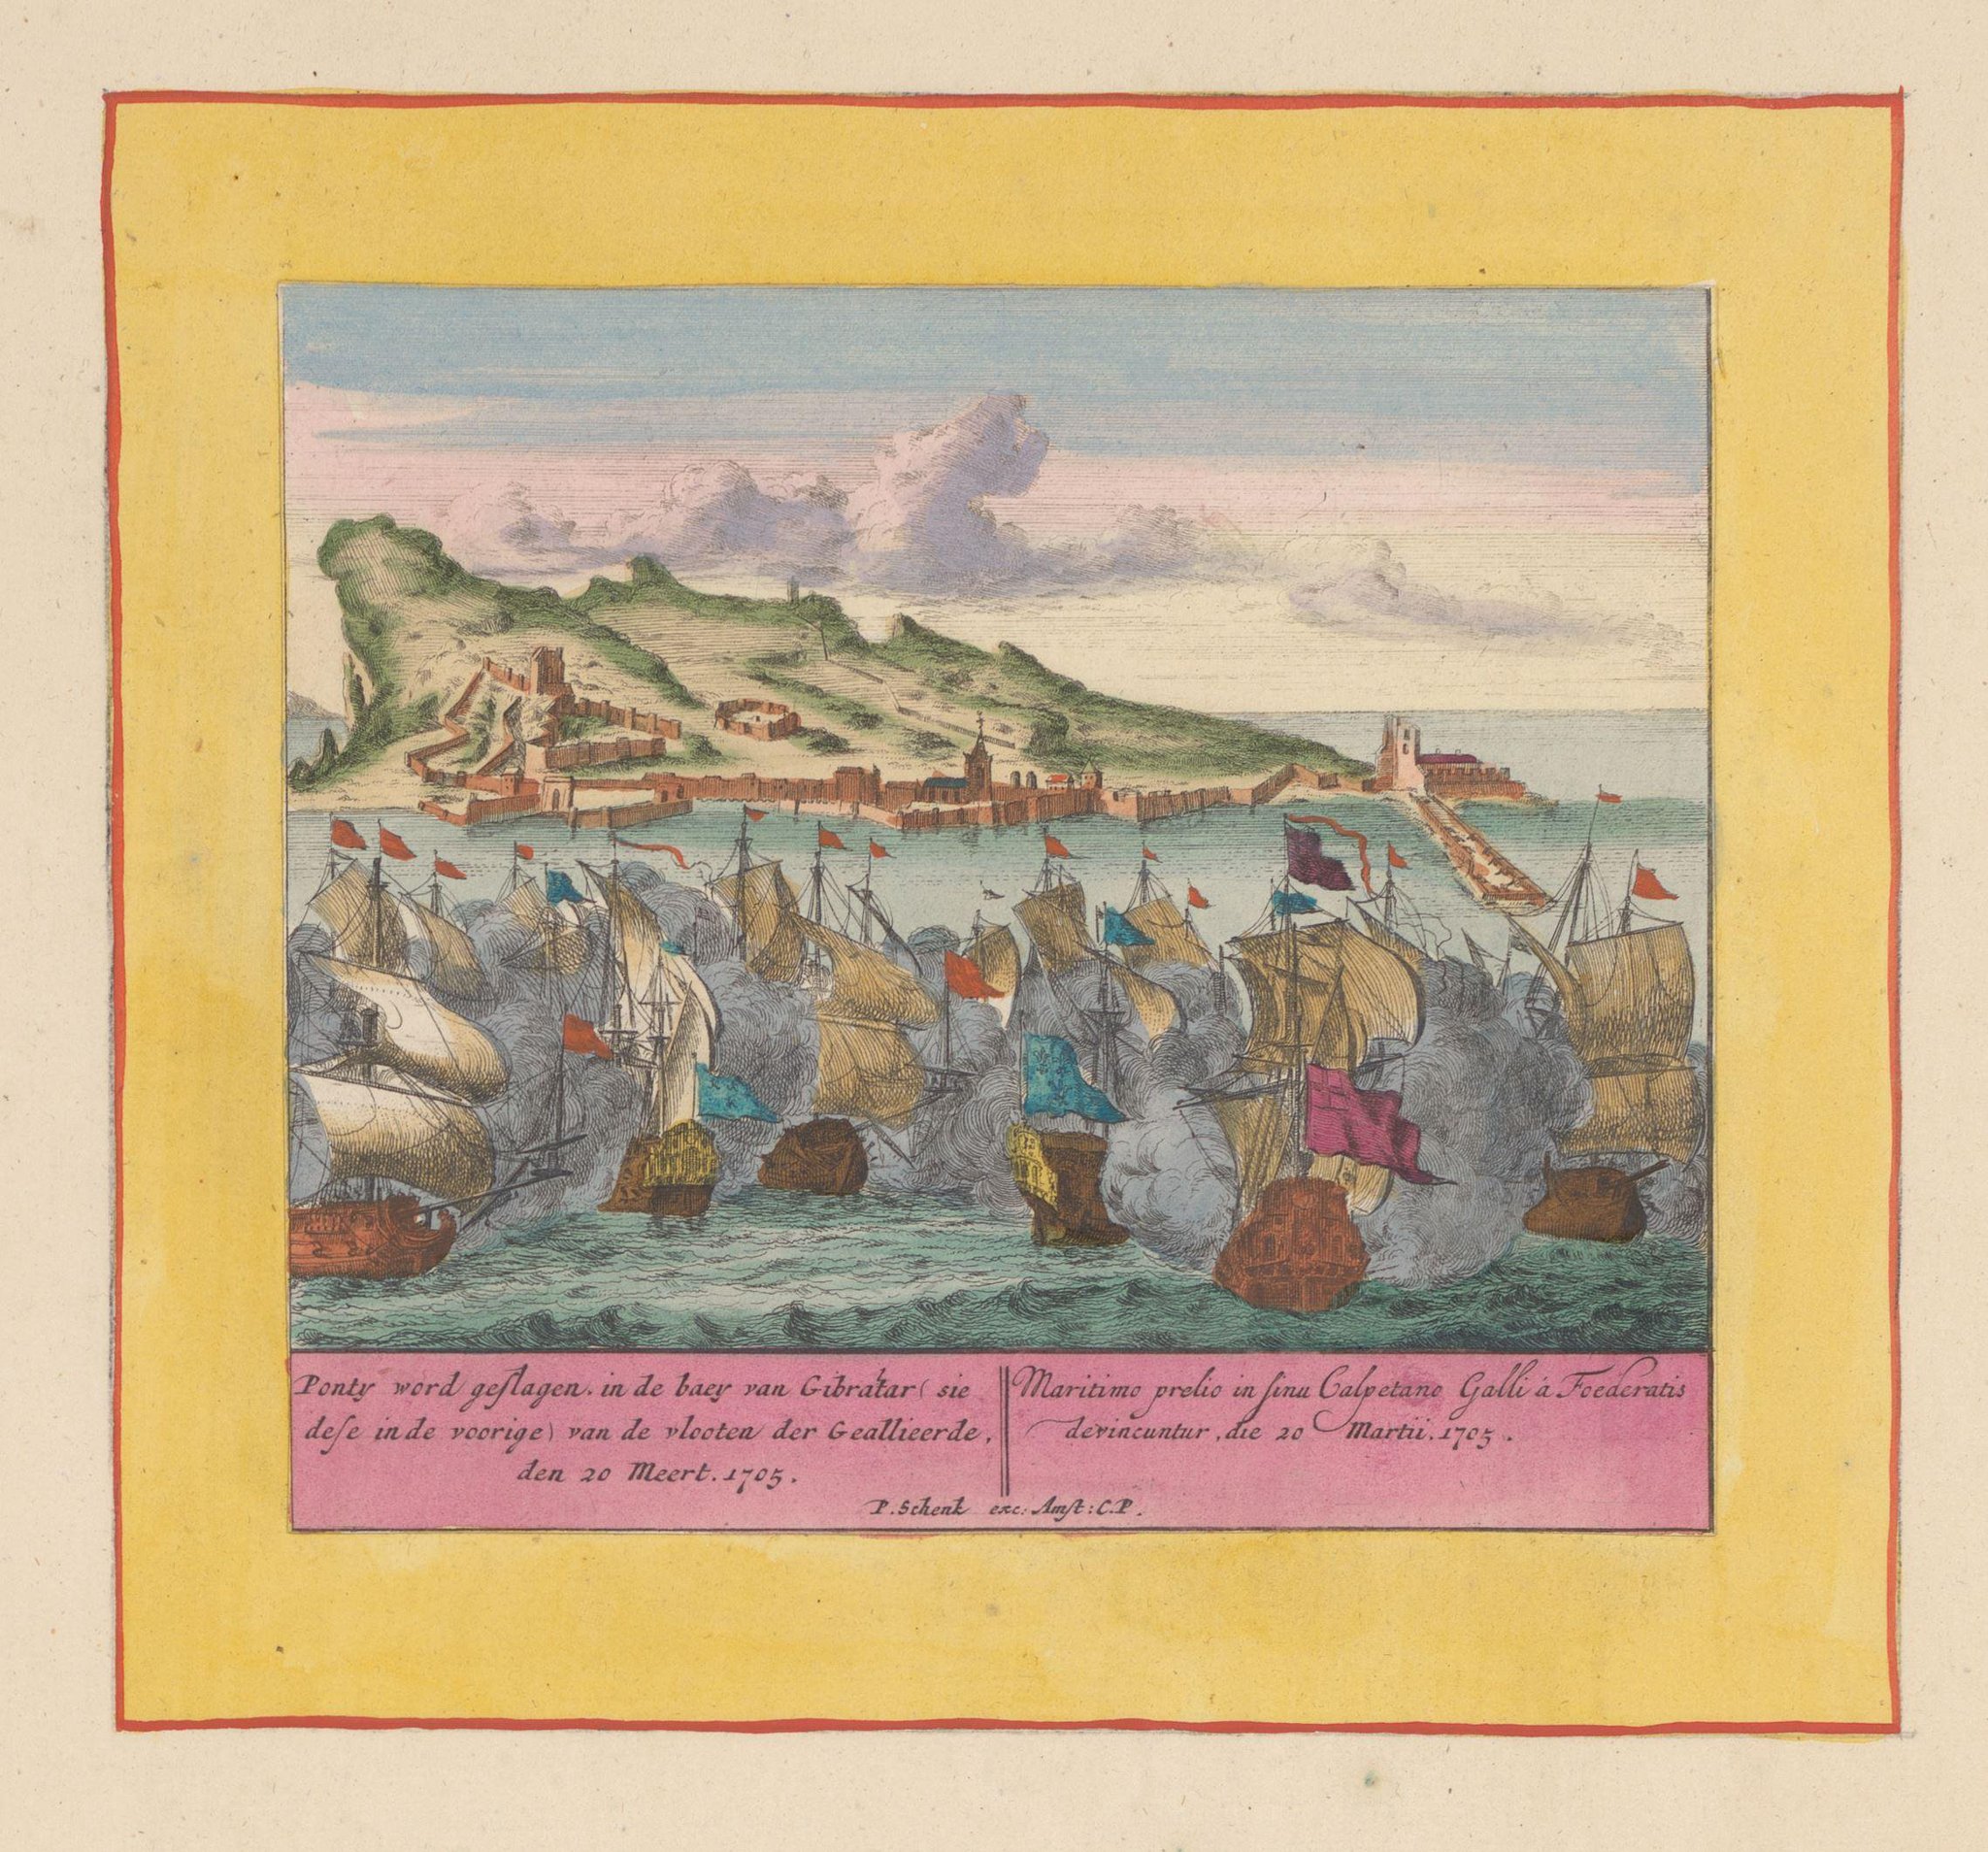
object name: book illustration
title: Zeeslag bij Gibraltar, 1705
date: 1707-1720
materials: paper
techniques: etching, hand coloring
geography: the hague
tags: battle (+ naval force)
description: Prent uit: Schouwburg van den oorlog, beginnende van Karel den II. tot op koning Karel den III. : bestaande in IX historische figuren op een olifants blad, als veldslagen, belegeringen te water en te lande, met de voornaamste vestingen. Amsterdam: Pieter Schenk, 1709.